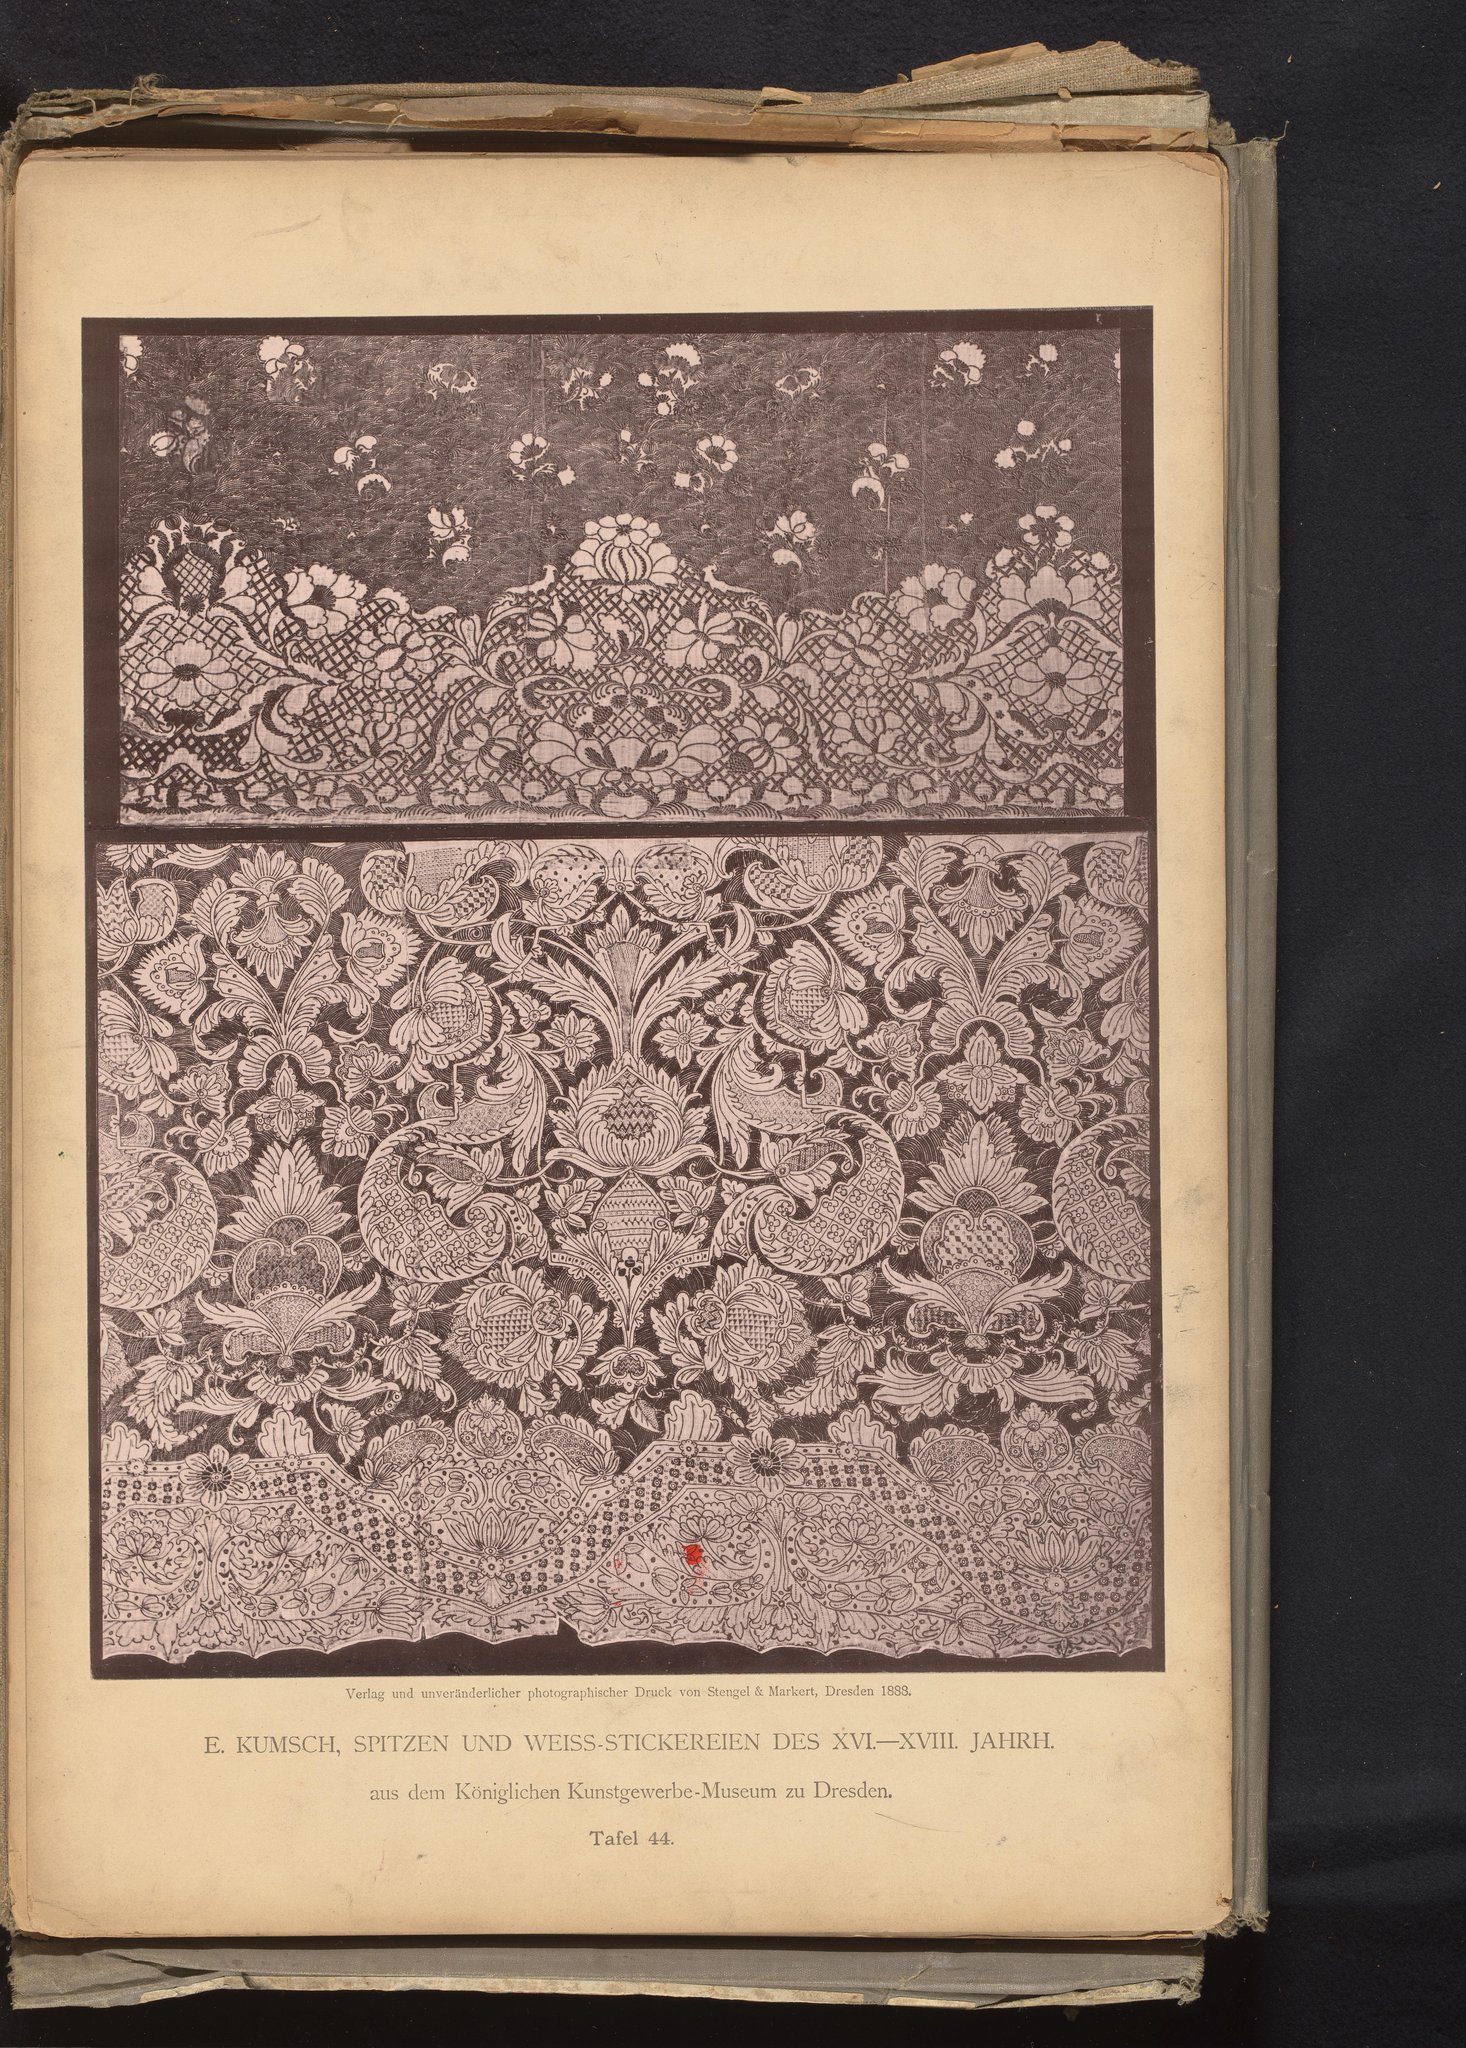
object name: photomechanical print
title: Twee stukken Duits borduurwerk uit circa 1720, uit de collectie van het Kunstgewerbemuseum in Dresden, Duitsland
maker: Anonymous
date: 1888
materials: paper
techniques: photograph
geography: dresden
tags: embroidery (ornamentation)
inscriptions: number: ‘Tafel 44.’, inscription: ‘E. KUMSCH, SPITZEN UND WEISS-STICKEREIEN DES XVI.-XVIII. JAHRH./ aus dem Königlichen Kunstgewerbe-Museum zu Dresden’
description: Deze prent maakt deel uit van een omslag met 49 prenten en een lijst van afbeeldingen.